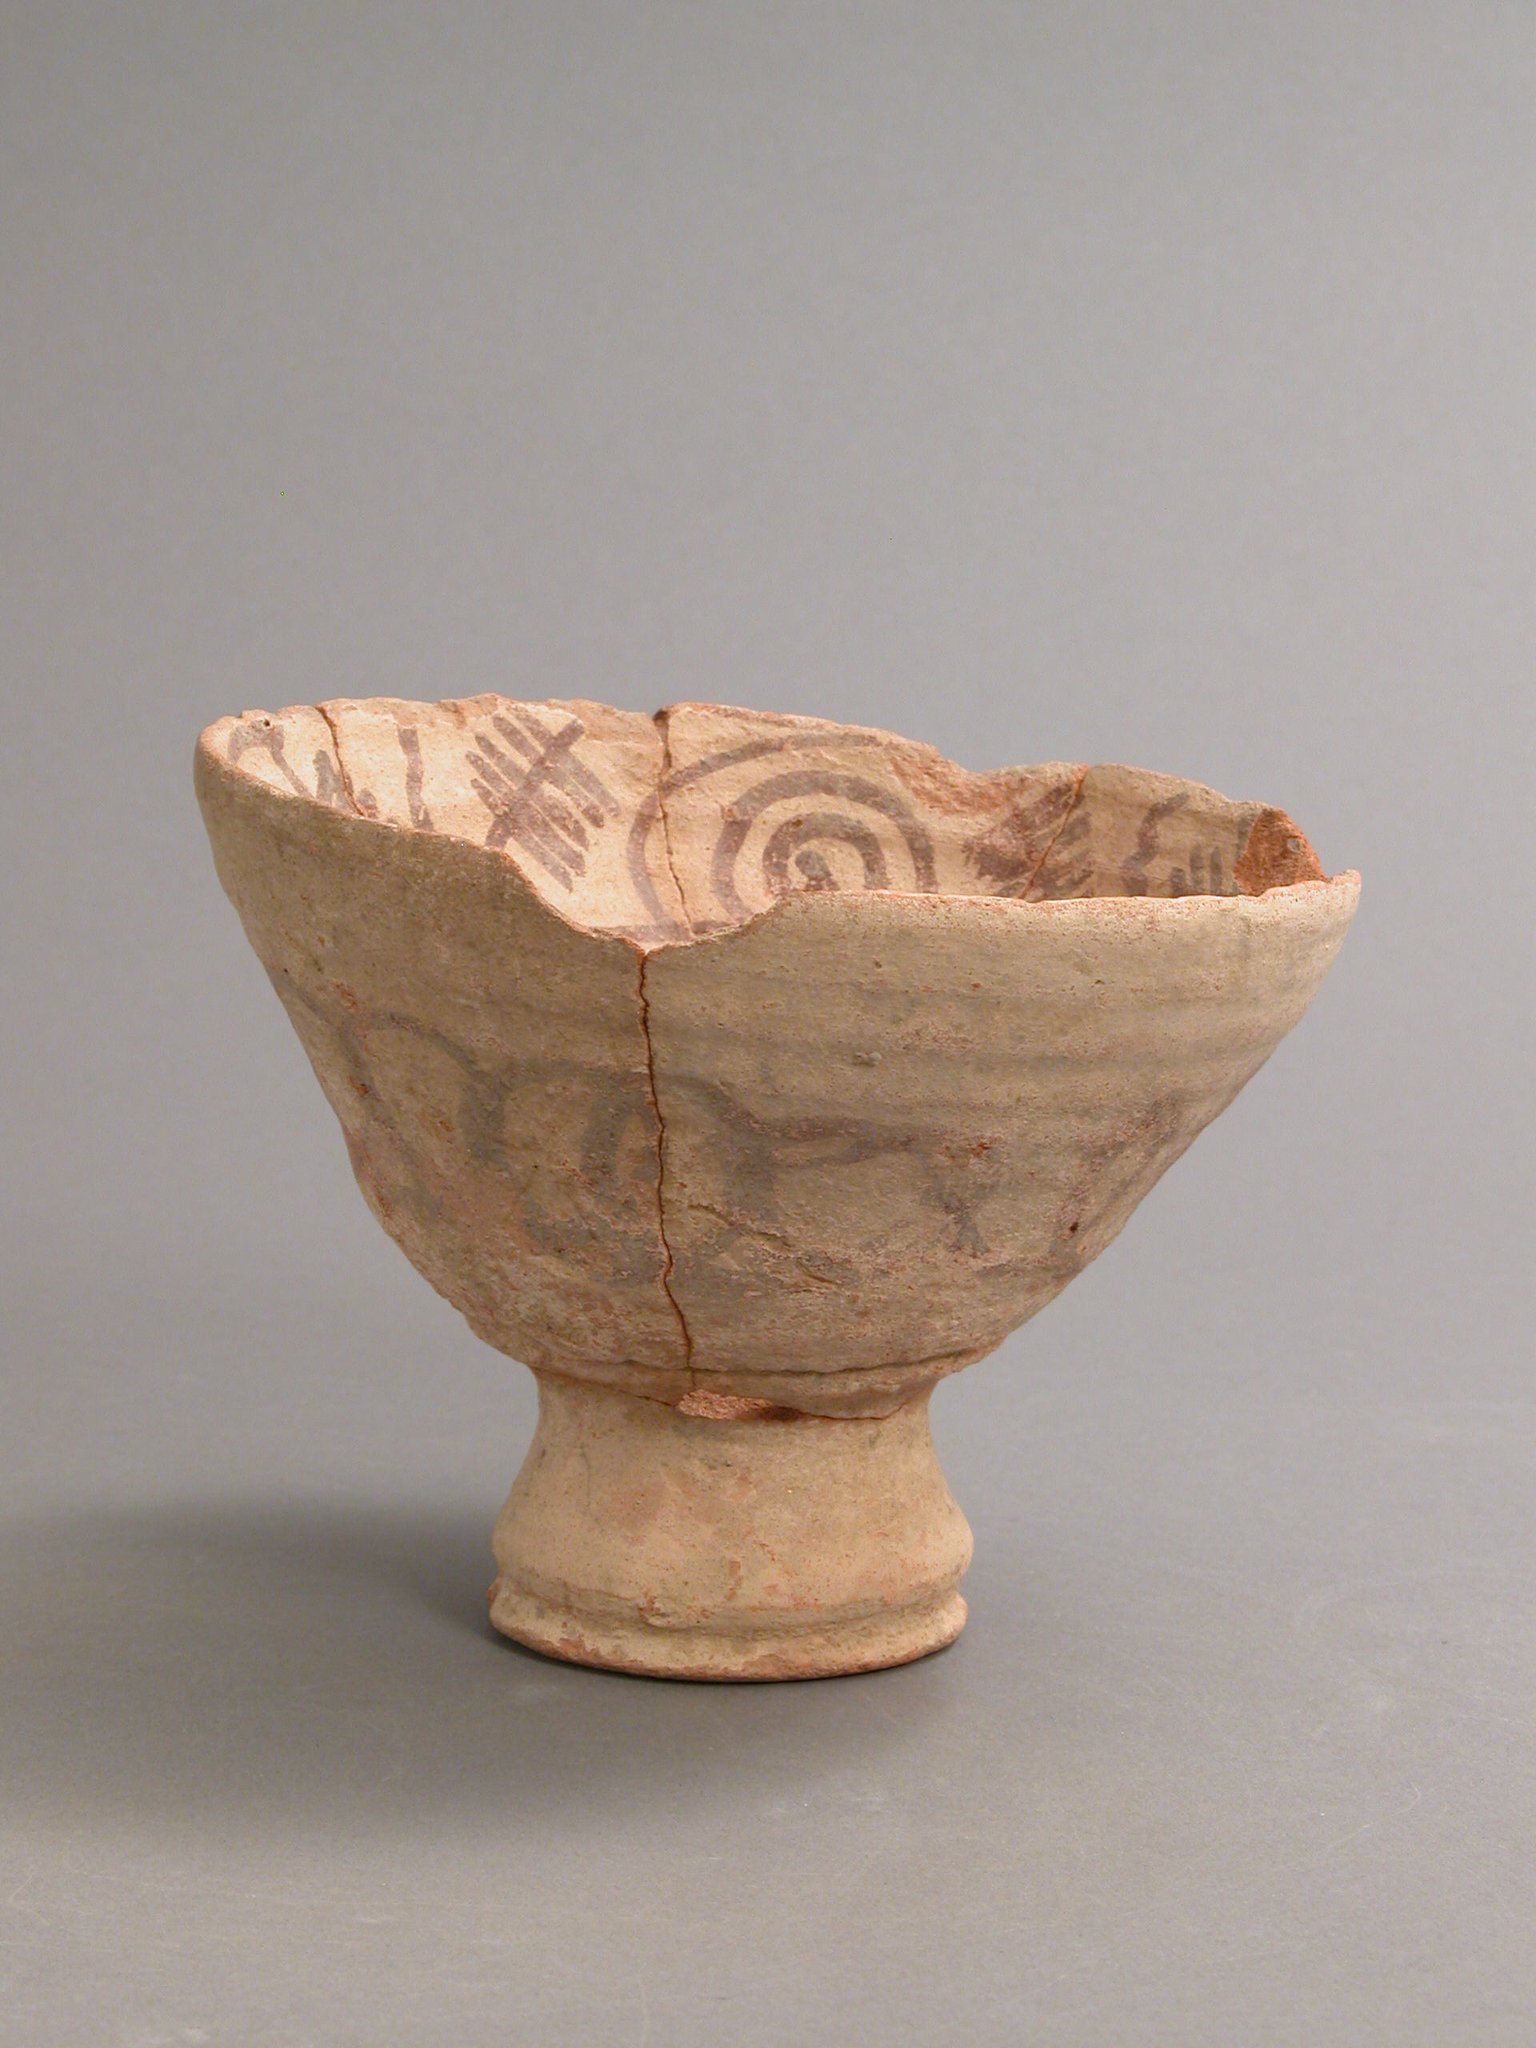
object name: cup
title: Cup with Foot and Geometric Decoration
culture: coptic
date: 301-700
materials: earthenware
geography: egypt